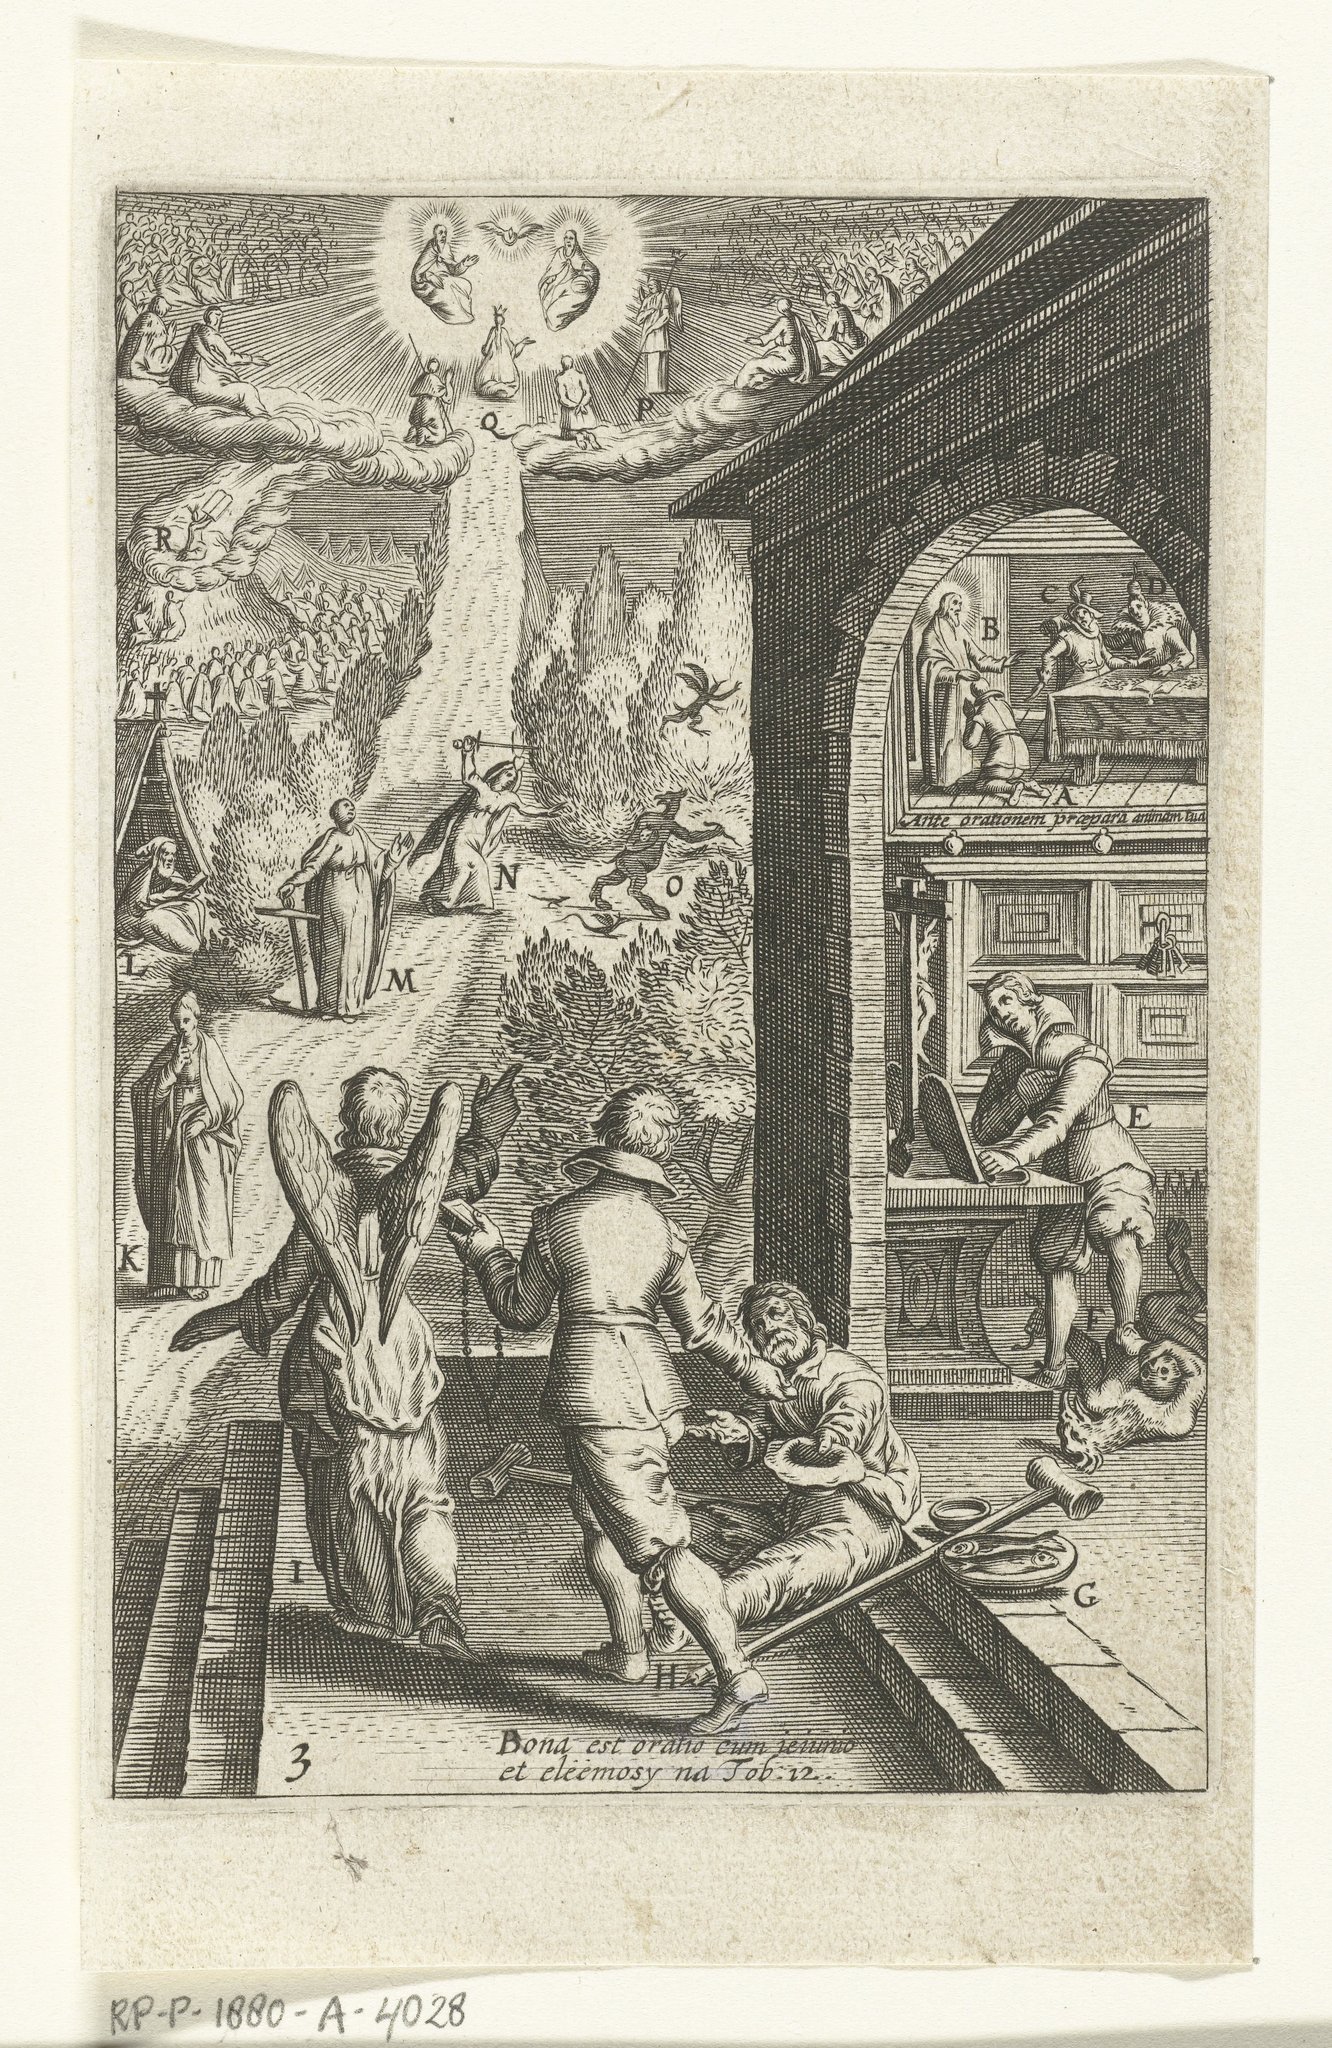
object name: book illustration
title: Den wech des eeuwich levens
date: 1620-1623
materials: paper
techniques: engraving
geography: antwerp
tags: giving alms or other charity, e.g.: handing out food, crutches, person with a physical disability, the life of man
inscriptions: collector's mark: Lugt 2228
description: Een man met bijbel en rozenkrans in de hand volgt een engel die wijst naar een verschijning van God in de hemel. De man geeft een bedelaar geld. Naast hem liggen zijn krukken. Een korte Latijnse tekst verwijst naar het boek Tobit, vers 12 waarin Tobias God dankt en looft.